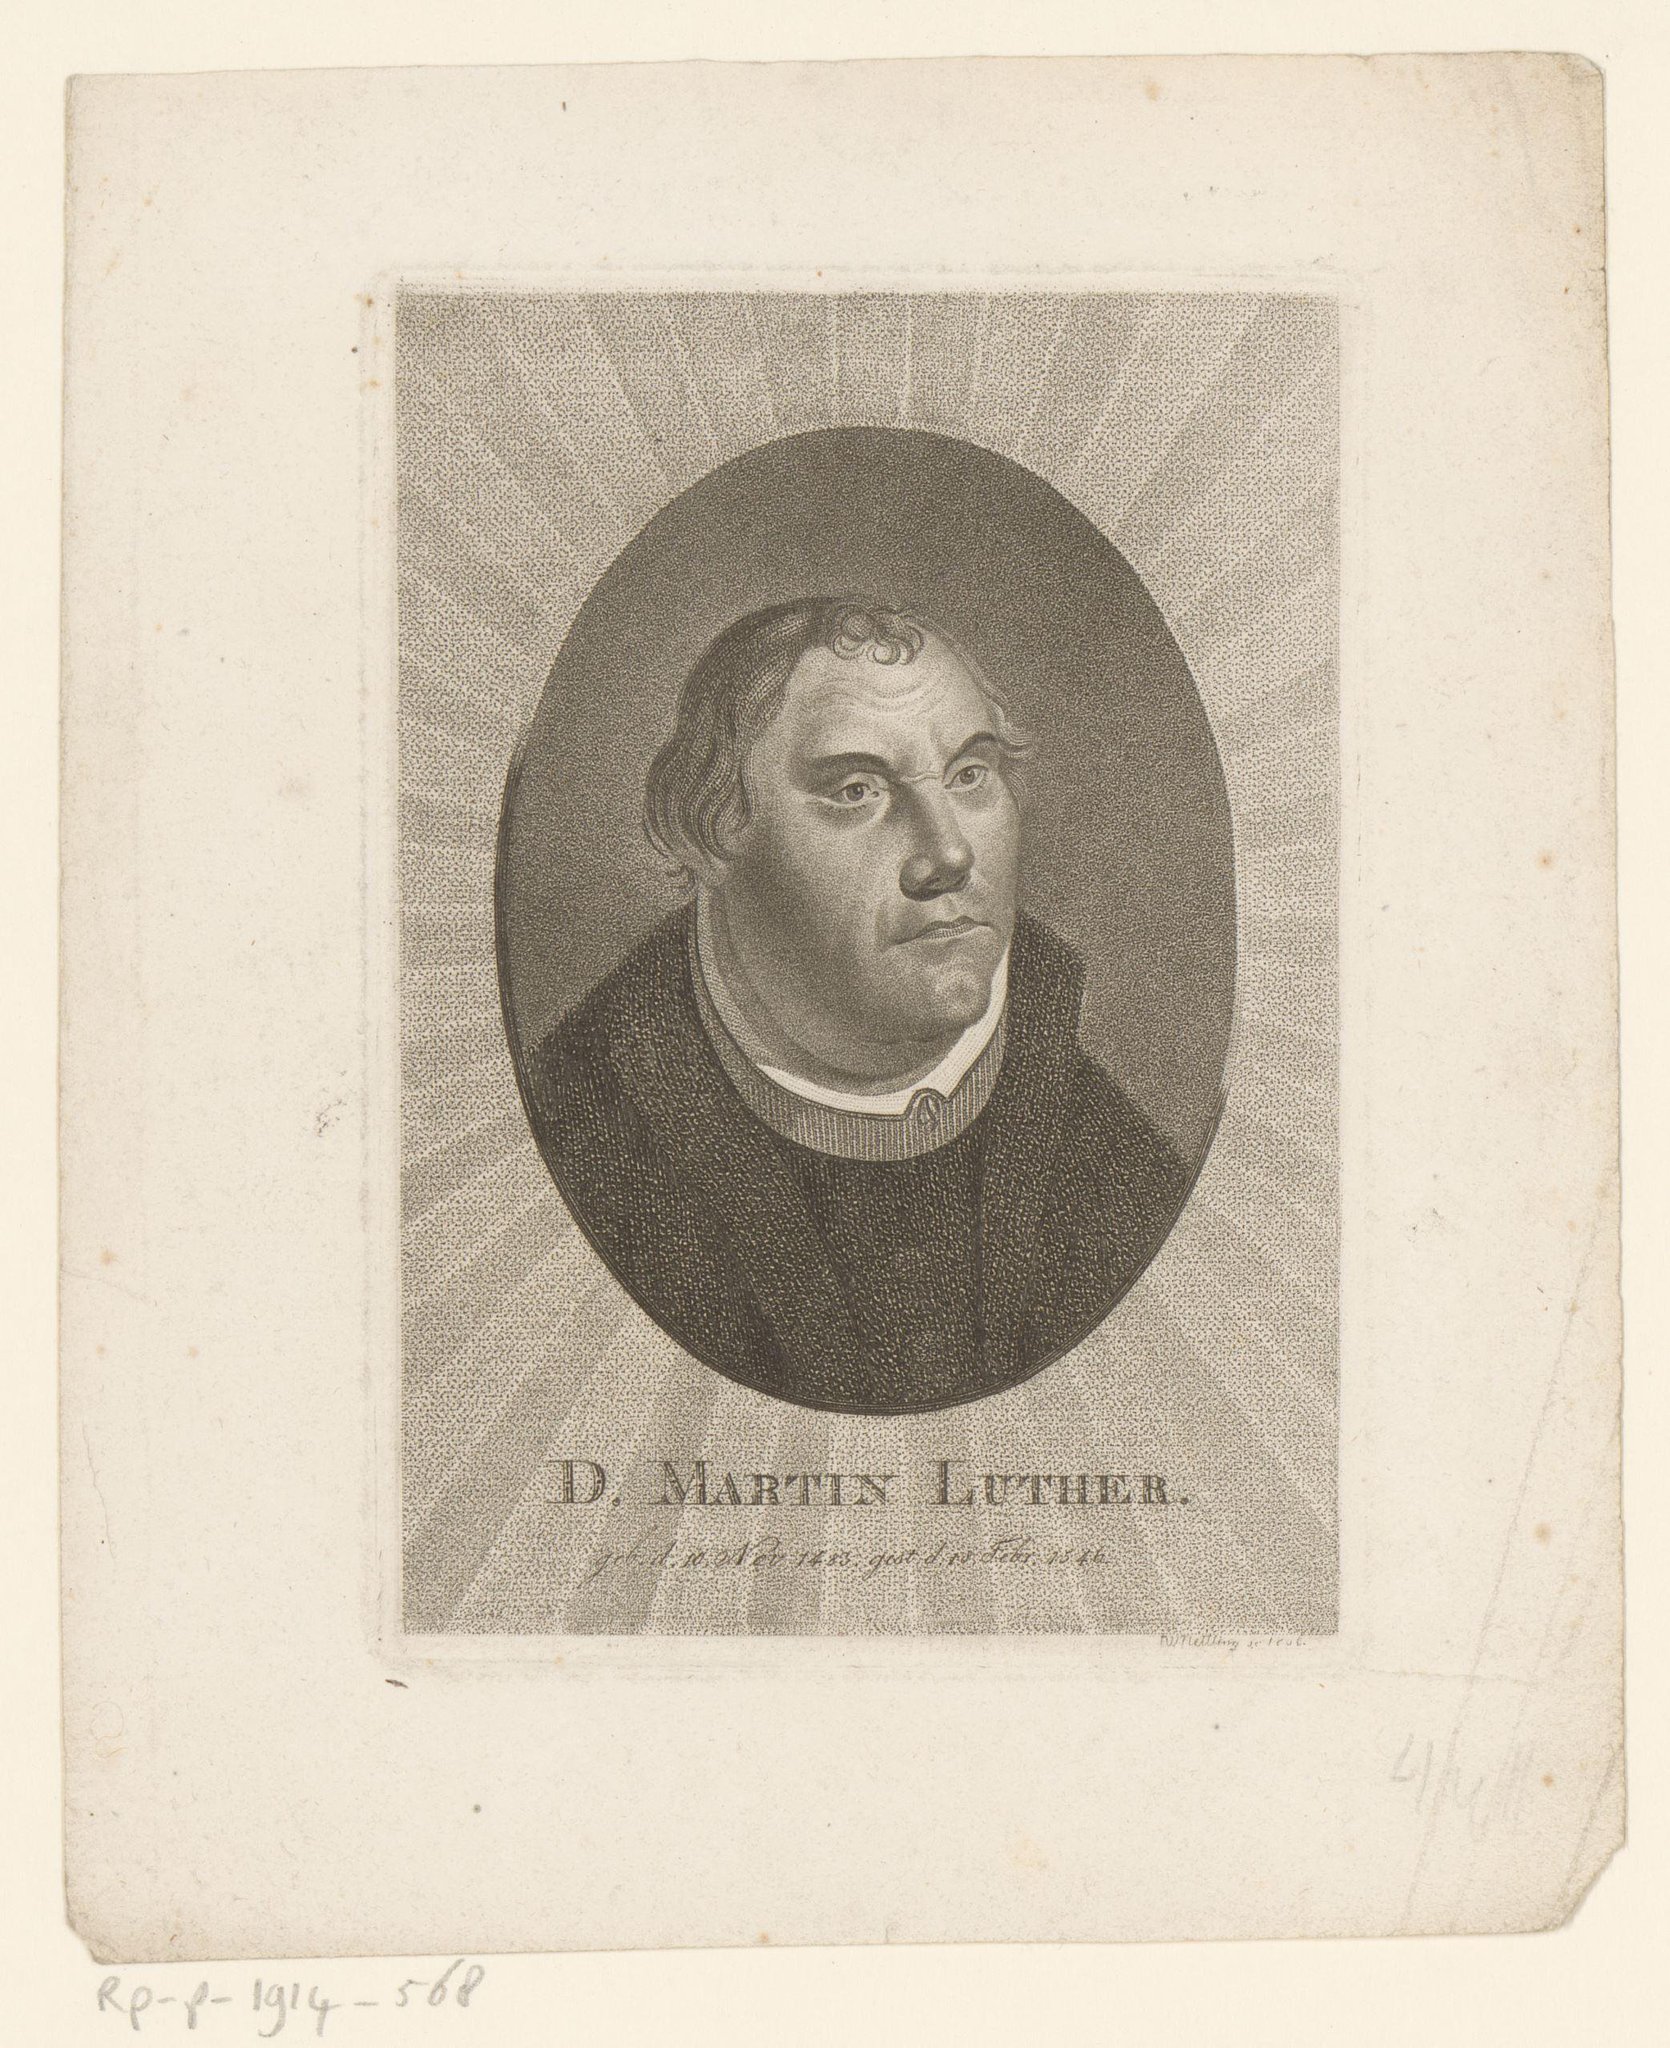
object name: print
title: Portret van Martin Luther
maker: friedrich wilhelm nettling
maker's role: print maker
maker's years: 1793-1824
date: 1793-1824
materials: paper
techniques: engraving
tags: priest, martin luther, theologian, historical persons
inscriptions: collector's mark: Lugt 2228